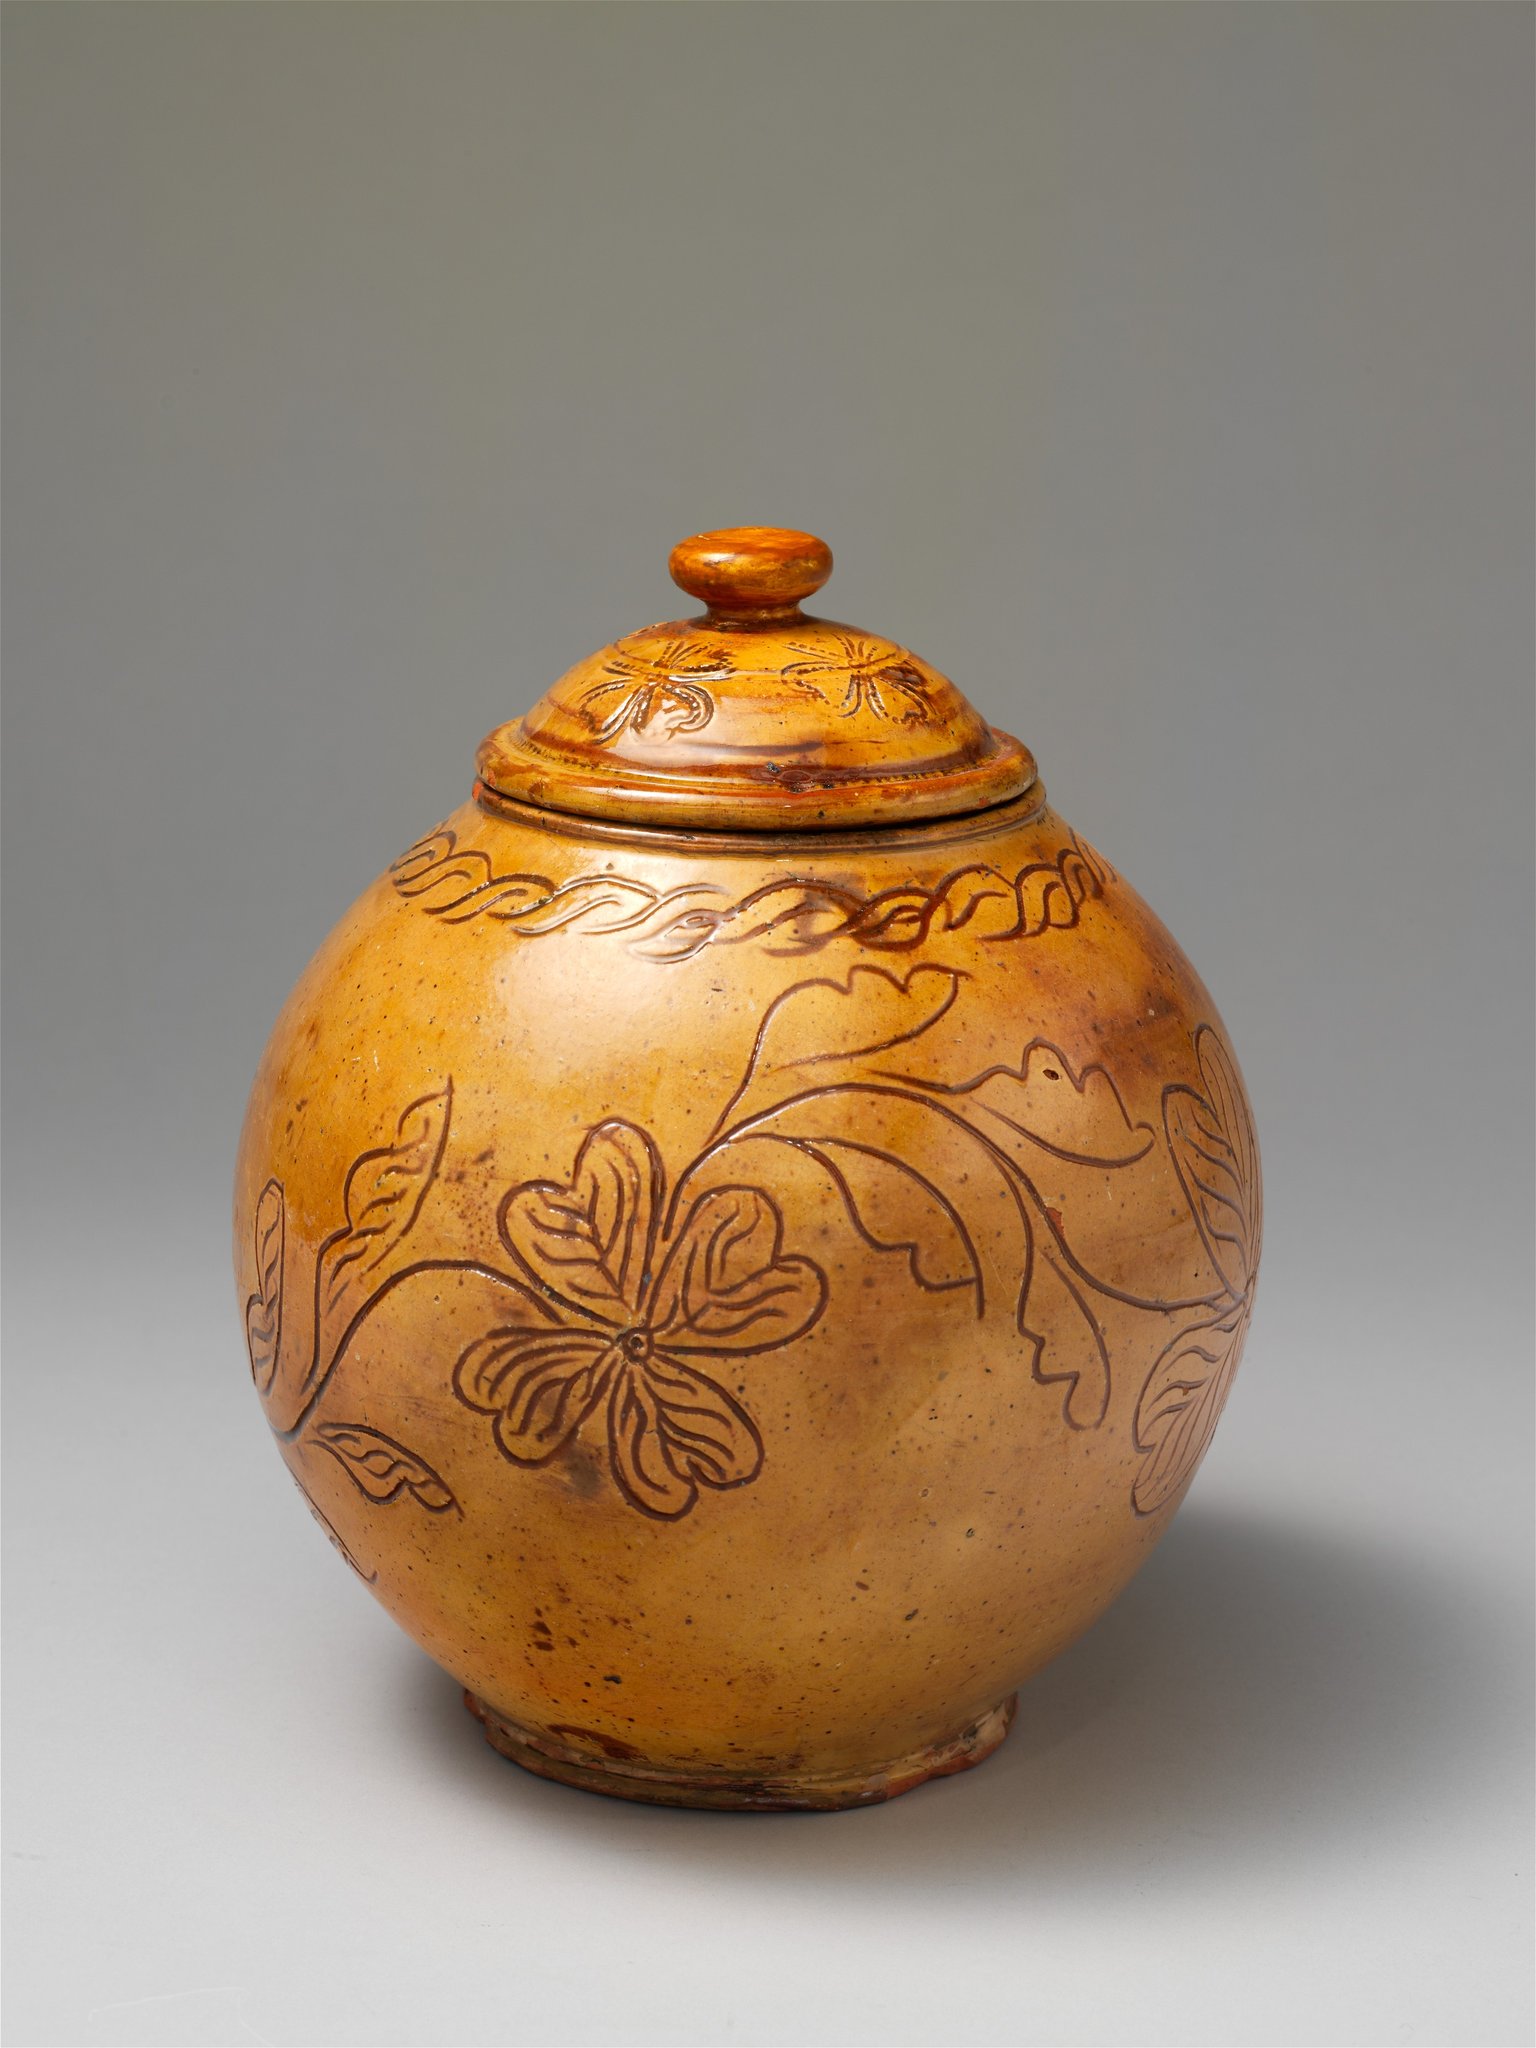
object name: jar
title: Covered jar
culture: american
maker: jacob scholl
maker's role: maker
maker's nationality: american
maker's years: 1781-1851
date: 1830-1840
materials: earthenware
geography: united states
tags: flowers